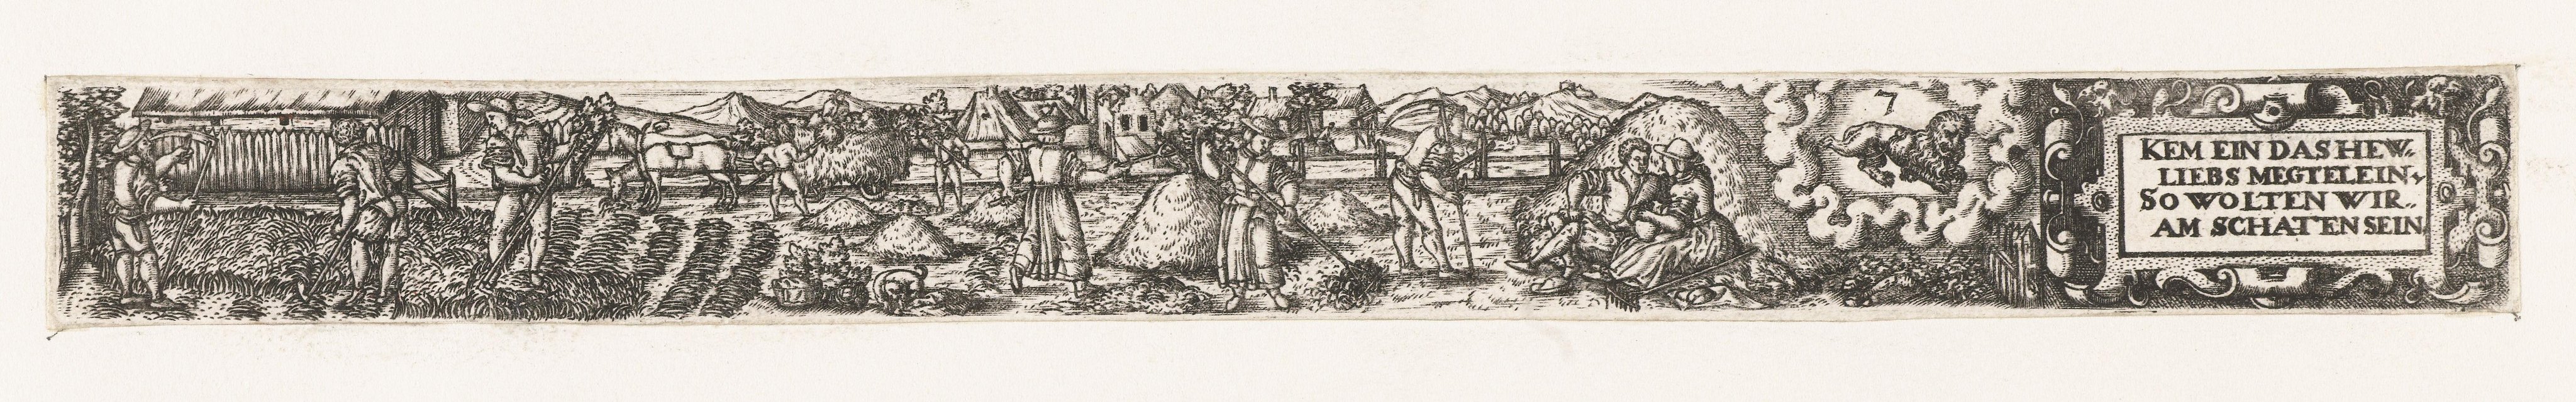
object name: print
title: Twaalf maanden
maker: Anonymous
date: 1584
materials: paper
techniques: engraving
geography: germany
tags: july; 'luglio' (ripa) (+ with zodiacal signs), july and its 'labours'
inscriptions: collector's mark: Lugt 240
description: Uit een serie van twaalf prenten, de verbeelding van de maand Juli. Links zijn drie mannen met een zeis het gras aan het maaien, in het midden wordt het gedrooge gras gehooid, rechts het sterrenbeeld Leeuw en een cartouche met de tekst: Kem ein das Hew, liebs Megtelein, So wolten wir am Schaten sein.